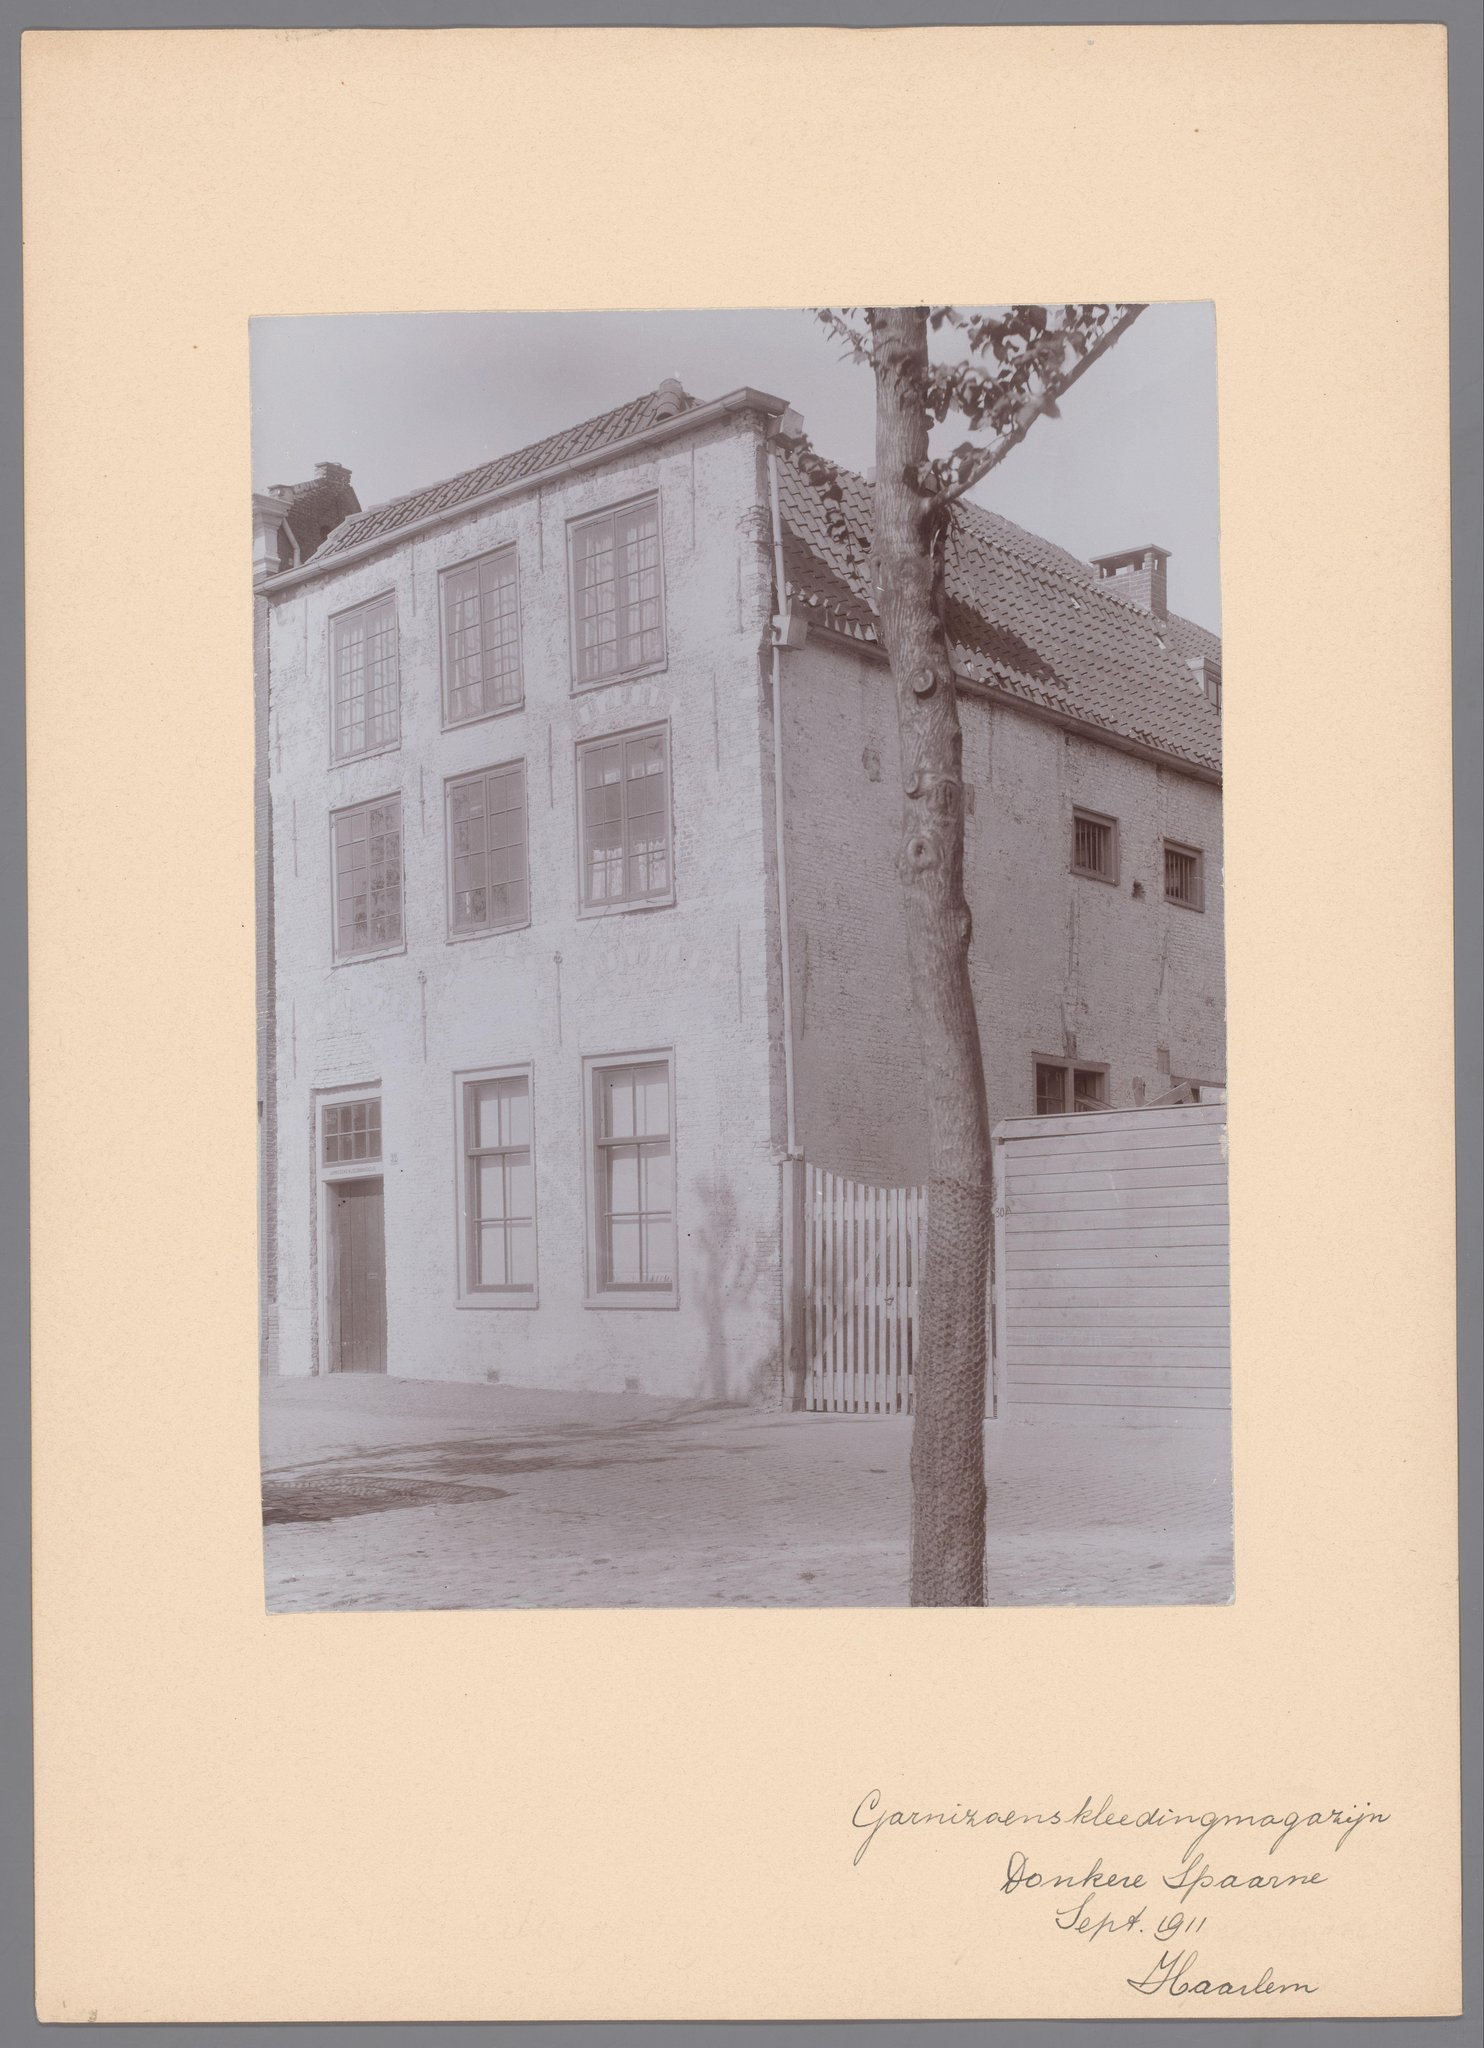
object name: photograph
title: Garnizoenen Kledingmagazijn aan het Donkere Spaarne te Haarlem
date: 1911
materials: cardboard, photographic support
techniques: collodion silver print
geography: donkere spaarne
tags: civic architecture; edifices; dwellings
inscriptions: annotation: ‘Garnizoenskleedingmagazijn/ Donkere Spaarne/ Sept. 1911/ Haarlem’